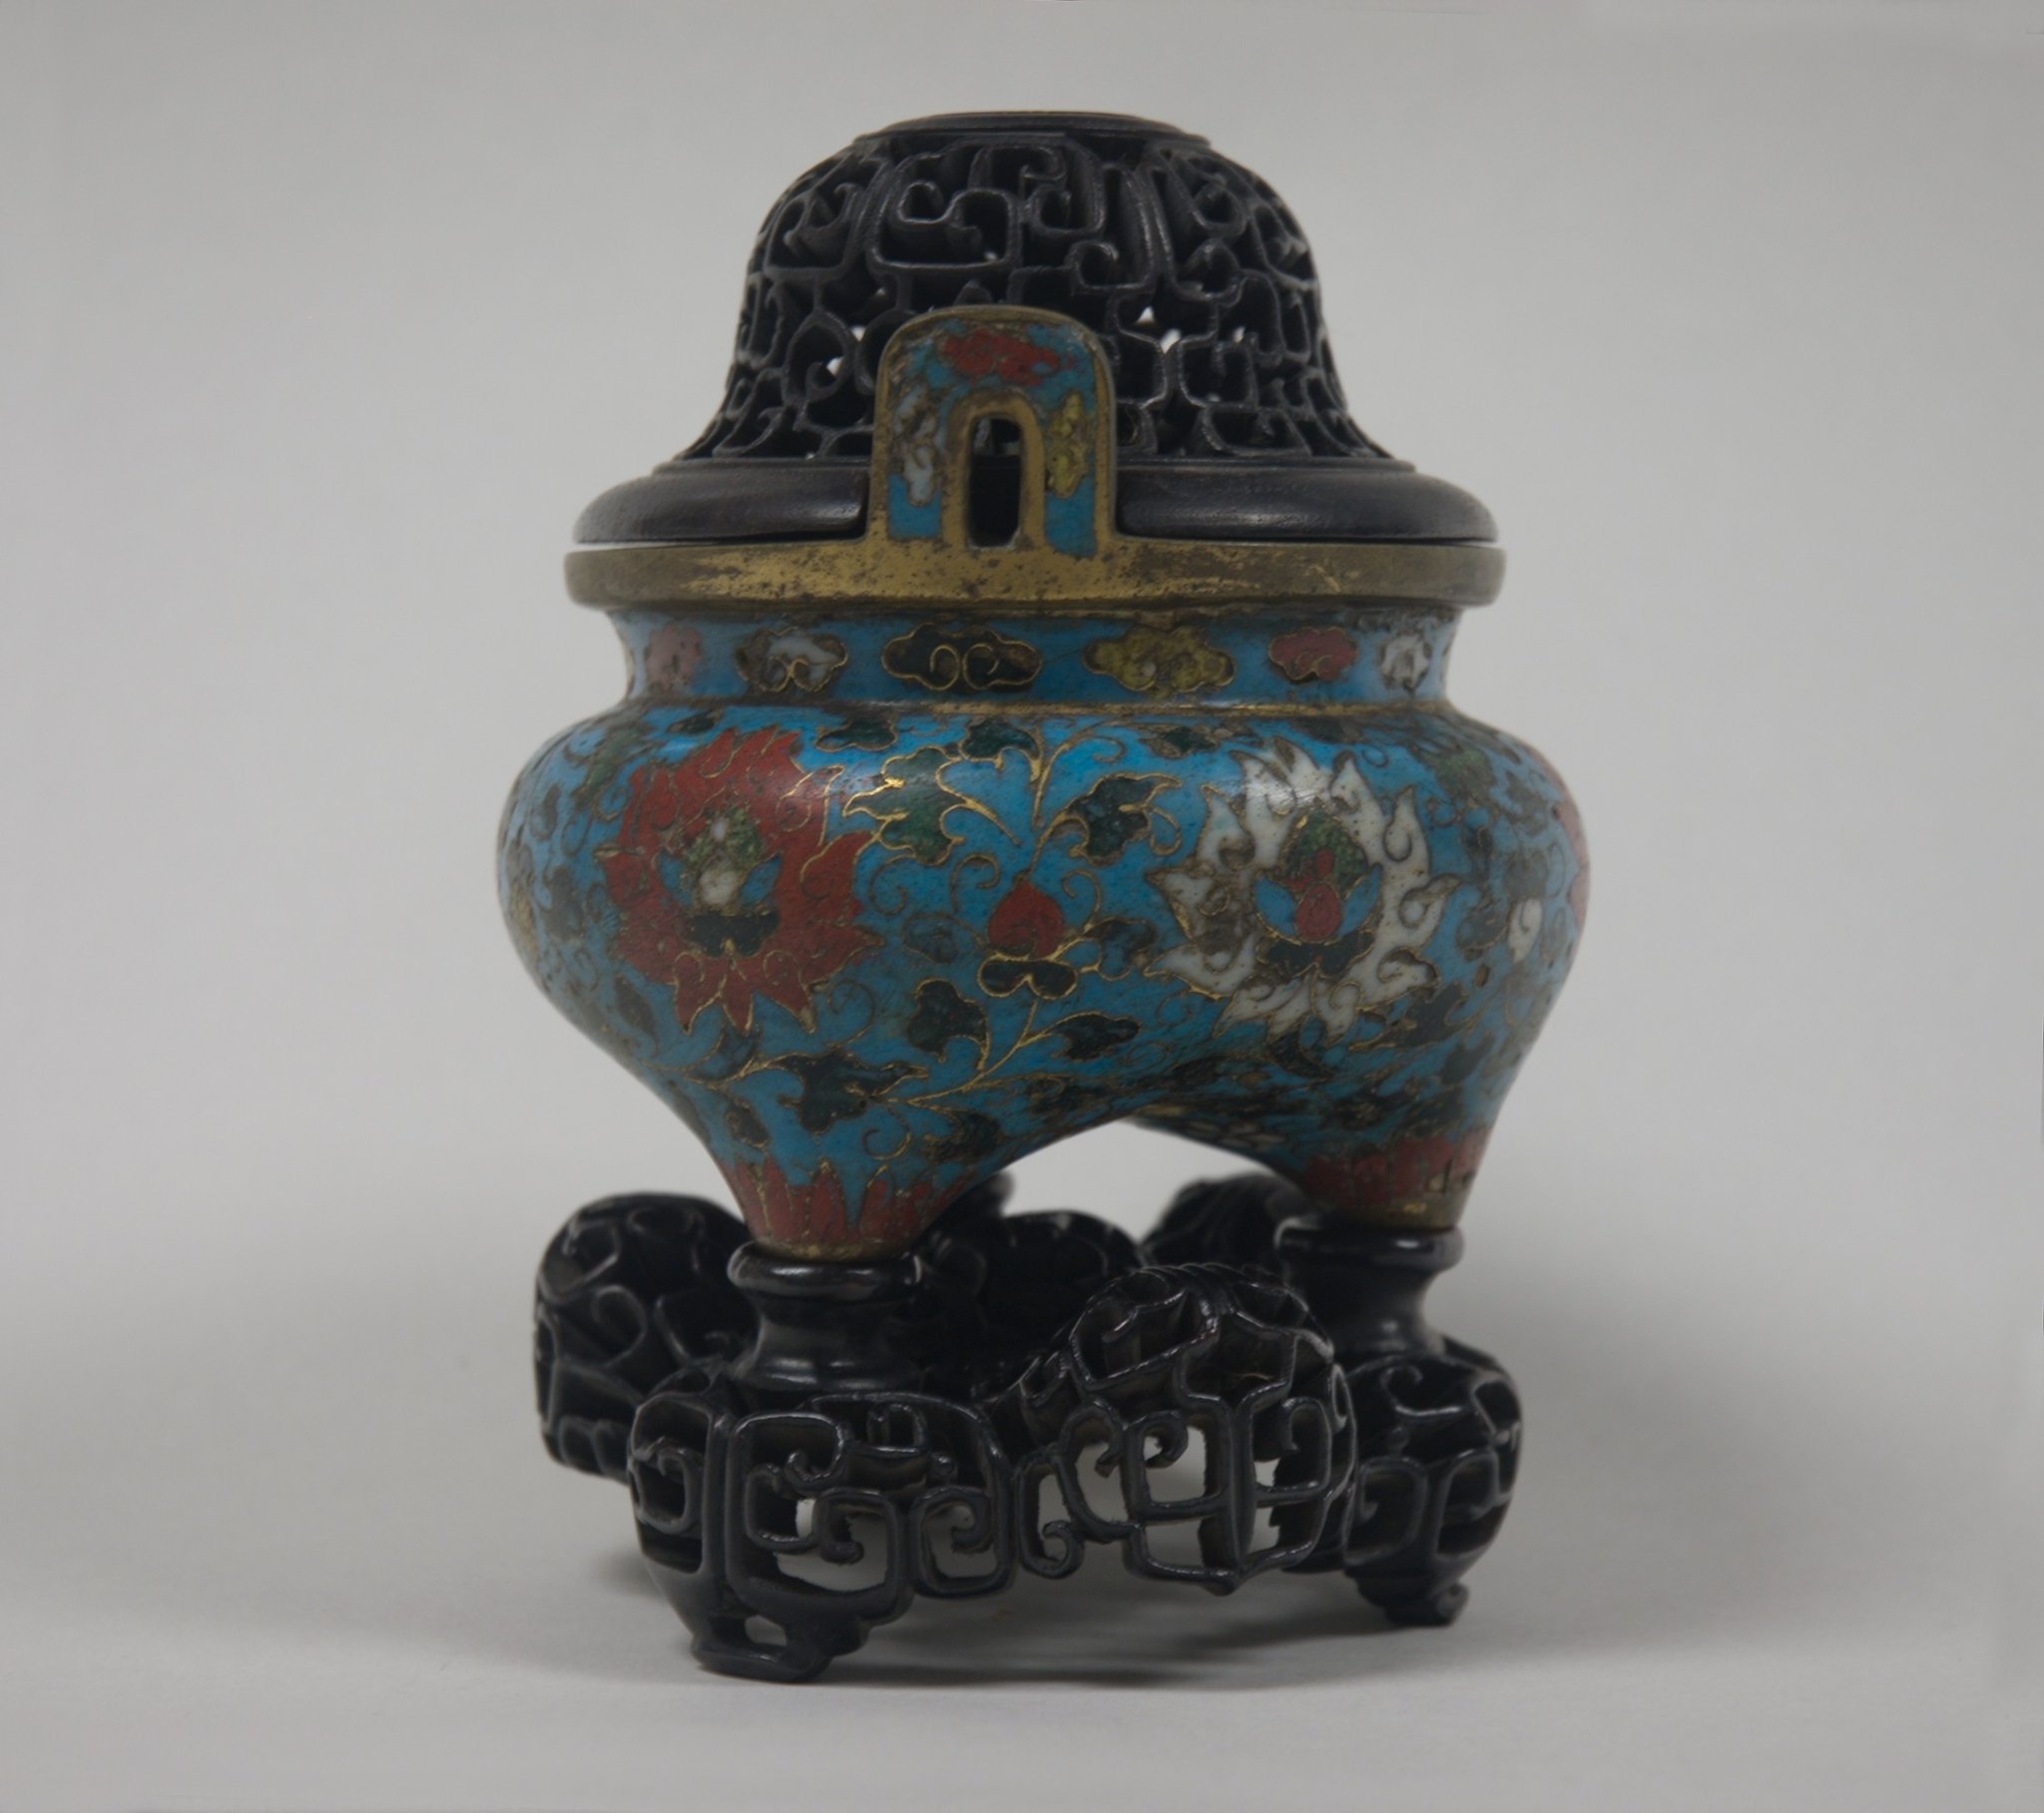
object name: incense burner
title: Incense burner with lotus scrolls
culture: chinese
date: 1467-1533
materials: enamel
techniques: enamel